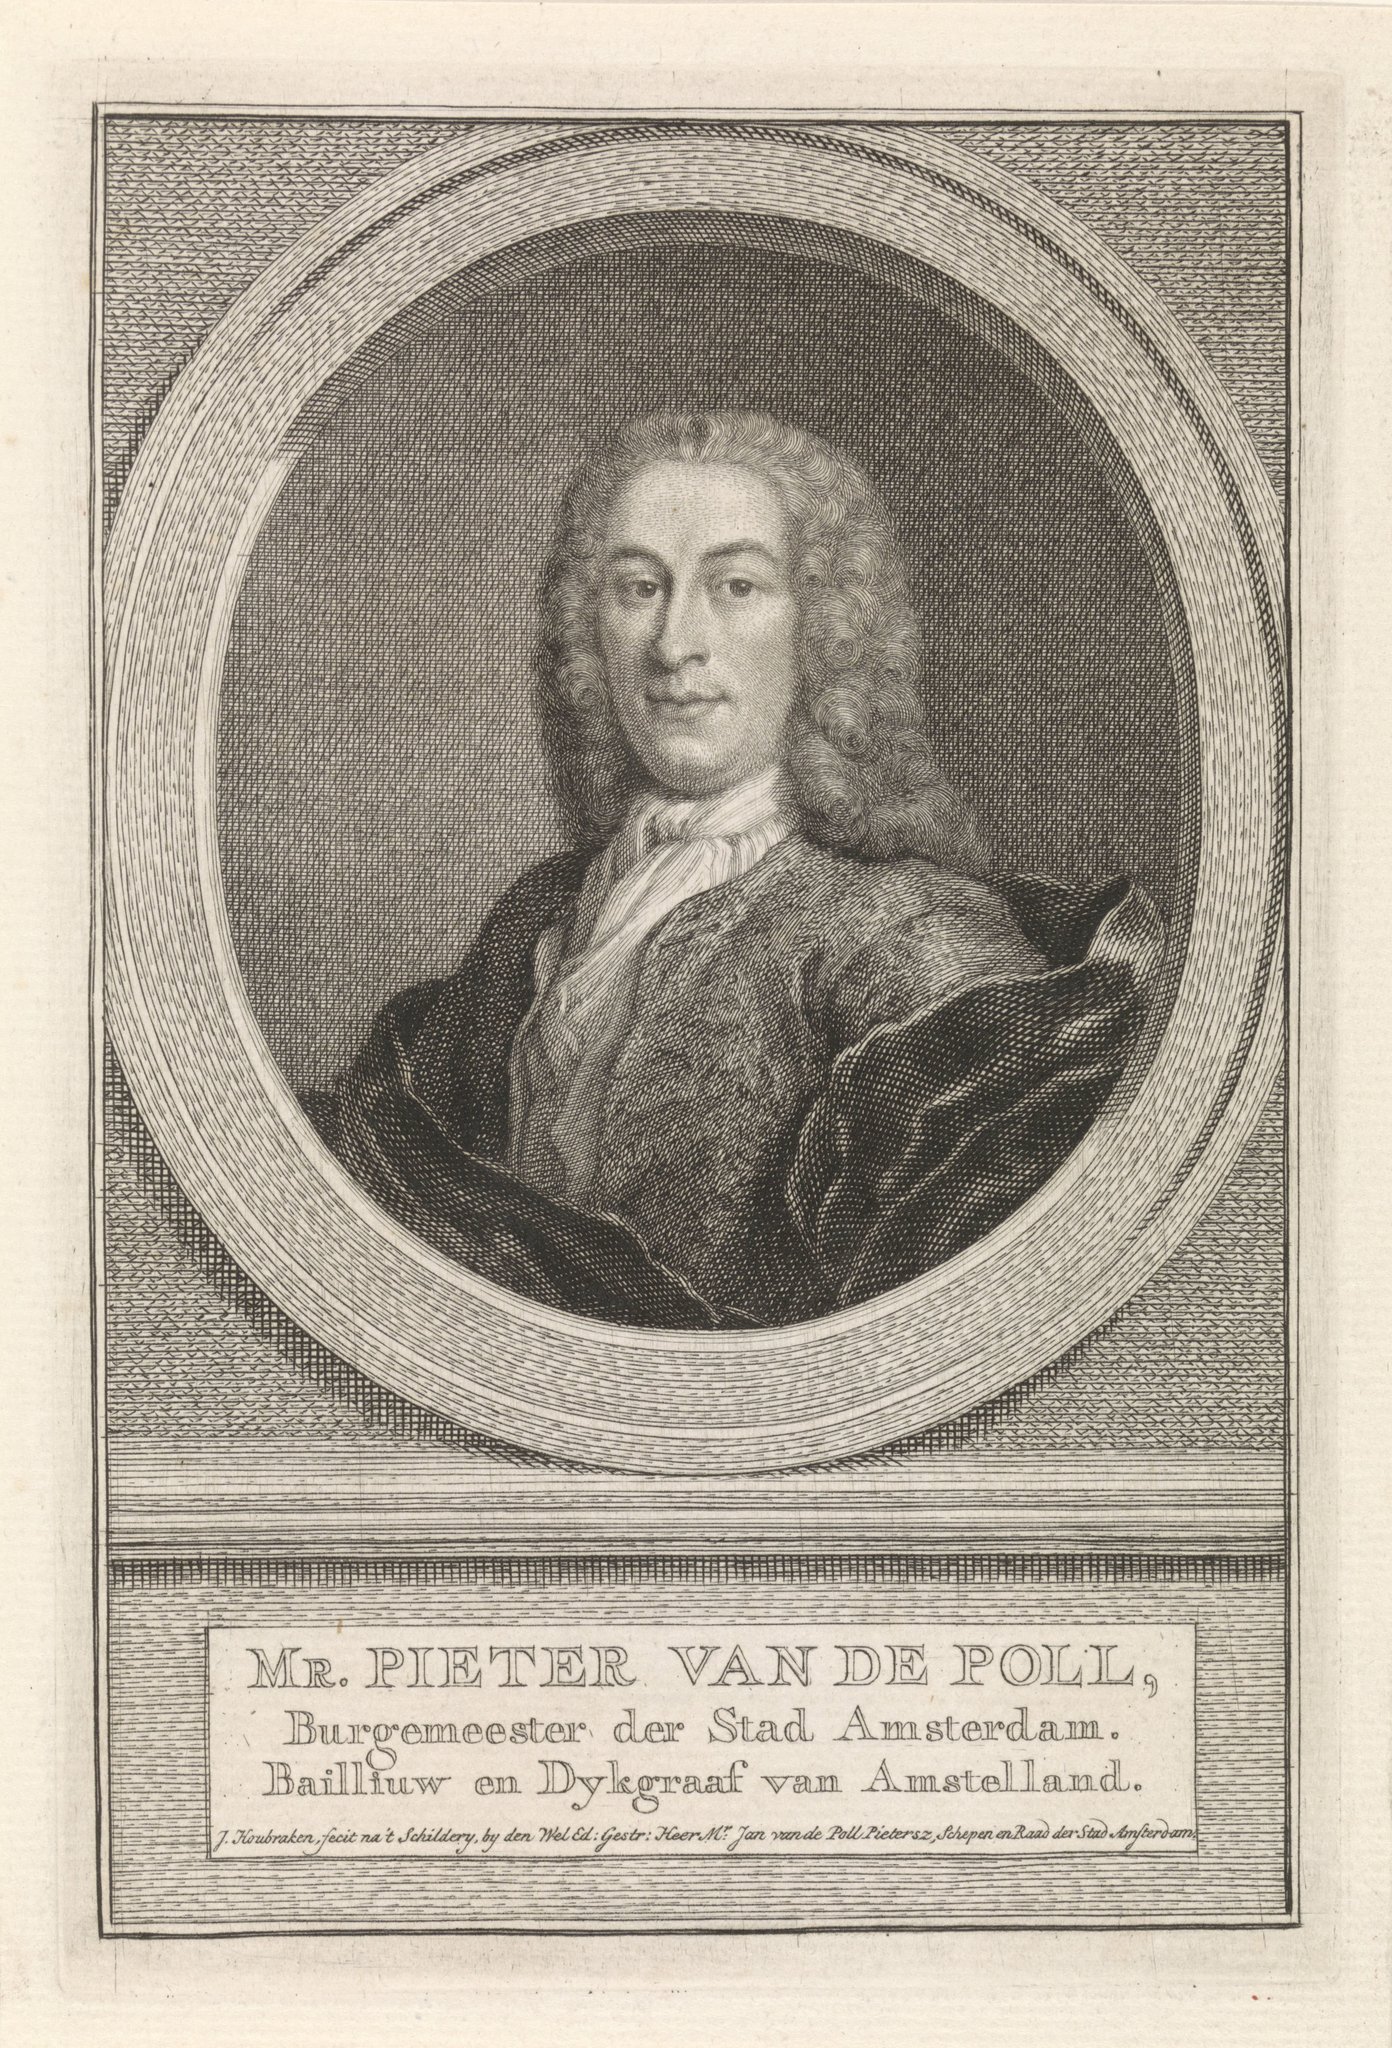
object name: print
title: Portret van Pieter van de Poll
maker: jacob houbraken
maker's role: draughtsman, print maker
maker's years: 1698-1780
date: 1749-1780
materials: paper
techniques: engraving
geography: amsterdam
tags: historical persons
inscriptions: collector's mark: Lugt 240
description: Deze prent is oorspronkelijk bedoeld als aanvulling op Jan Wagenaars ‘Vaderlandsche historie’* en was zo vanaf 1796 verkrijgbaar bij Johannes Allart te Amsterdam. Voor de advertentie waarin Allart de 60 portretten en 7 platen, allen gegraveerd door Houbraken, ter aanvulling op Wagenaars ‘Vaderlandsche historie’ aanbiedt, zie RP-P-OB-77.766. *Van dit werk zijn in de achttiende eeuw meerdere uitgaves verschenen, zoals: Wagenaar, Jan. Vaderlandsche historie, vervattende de geschiedenissen der Vereenigde Nederlanden (…). 21 delen. Amsterdam: Isaak Tirion, 1749-1759. Wagenaar, Jan. Vaderlandsche historie, vervattende de geschiedenissen der nu Vereenigde Nederlanden (…). 21 delen. Amsterdam: weduwe Isaak Tirion, 1770. Wagenaar, Jan. Vaderlandsche historie, vervattende de geschiedenissen der nu Vereenigde Nederlanden (…). 21 delen. Amsterdam, Leiden, Dordrecht en Harlingen: P. Schouten e.a., 1782. Wagenaar, Jan. Vaderlandsche historie, vervattende de geschiedenissen der nu Vereenigde Nederlanden (…). 21 delen. Amsterdam: Johannes Allart, 1790-1796.